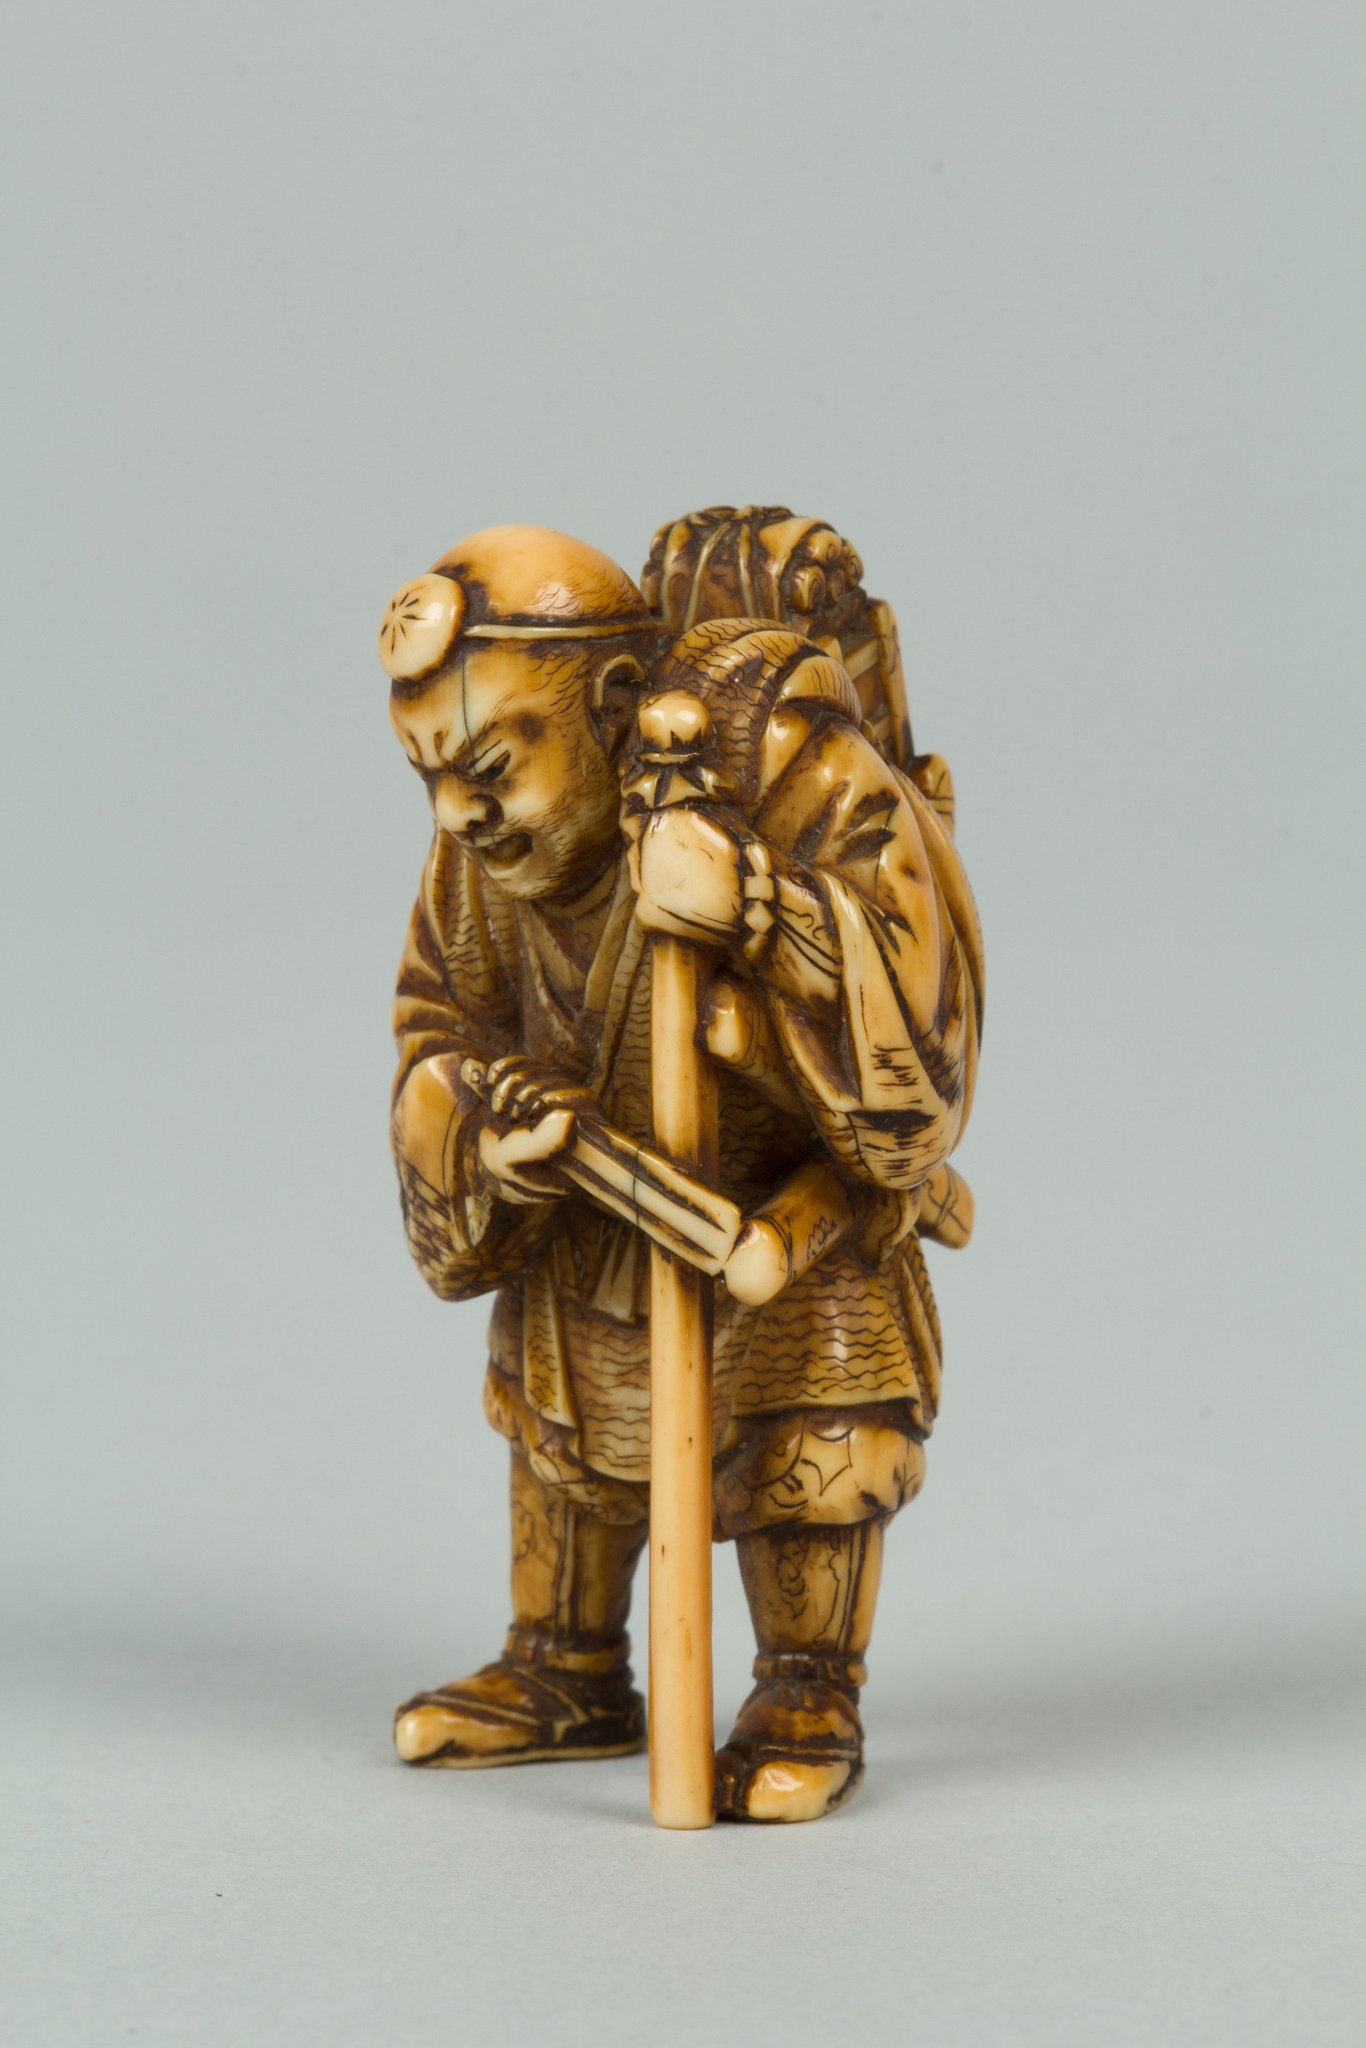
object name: netsuke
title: Netsuke of Old Man with a Pack on His Back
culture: japanese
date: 1801-1900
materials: ivory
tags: men